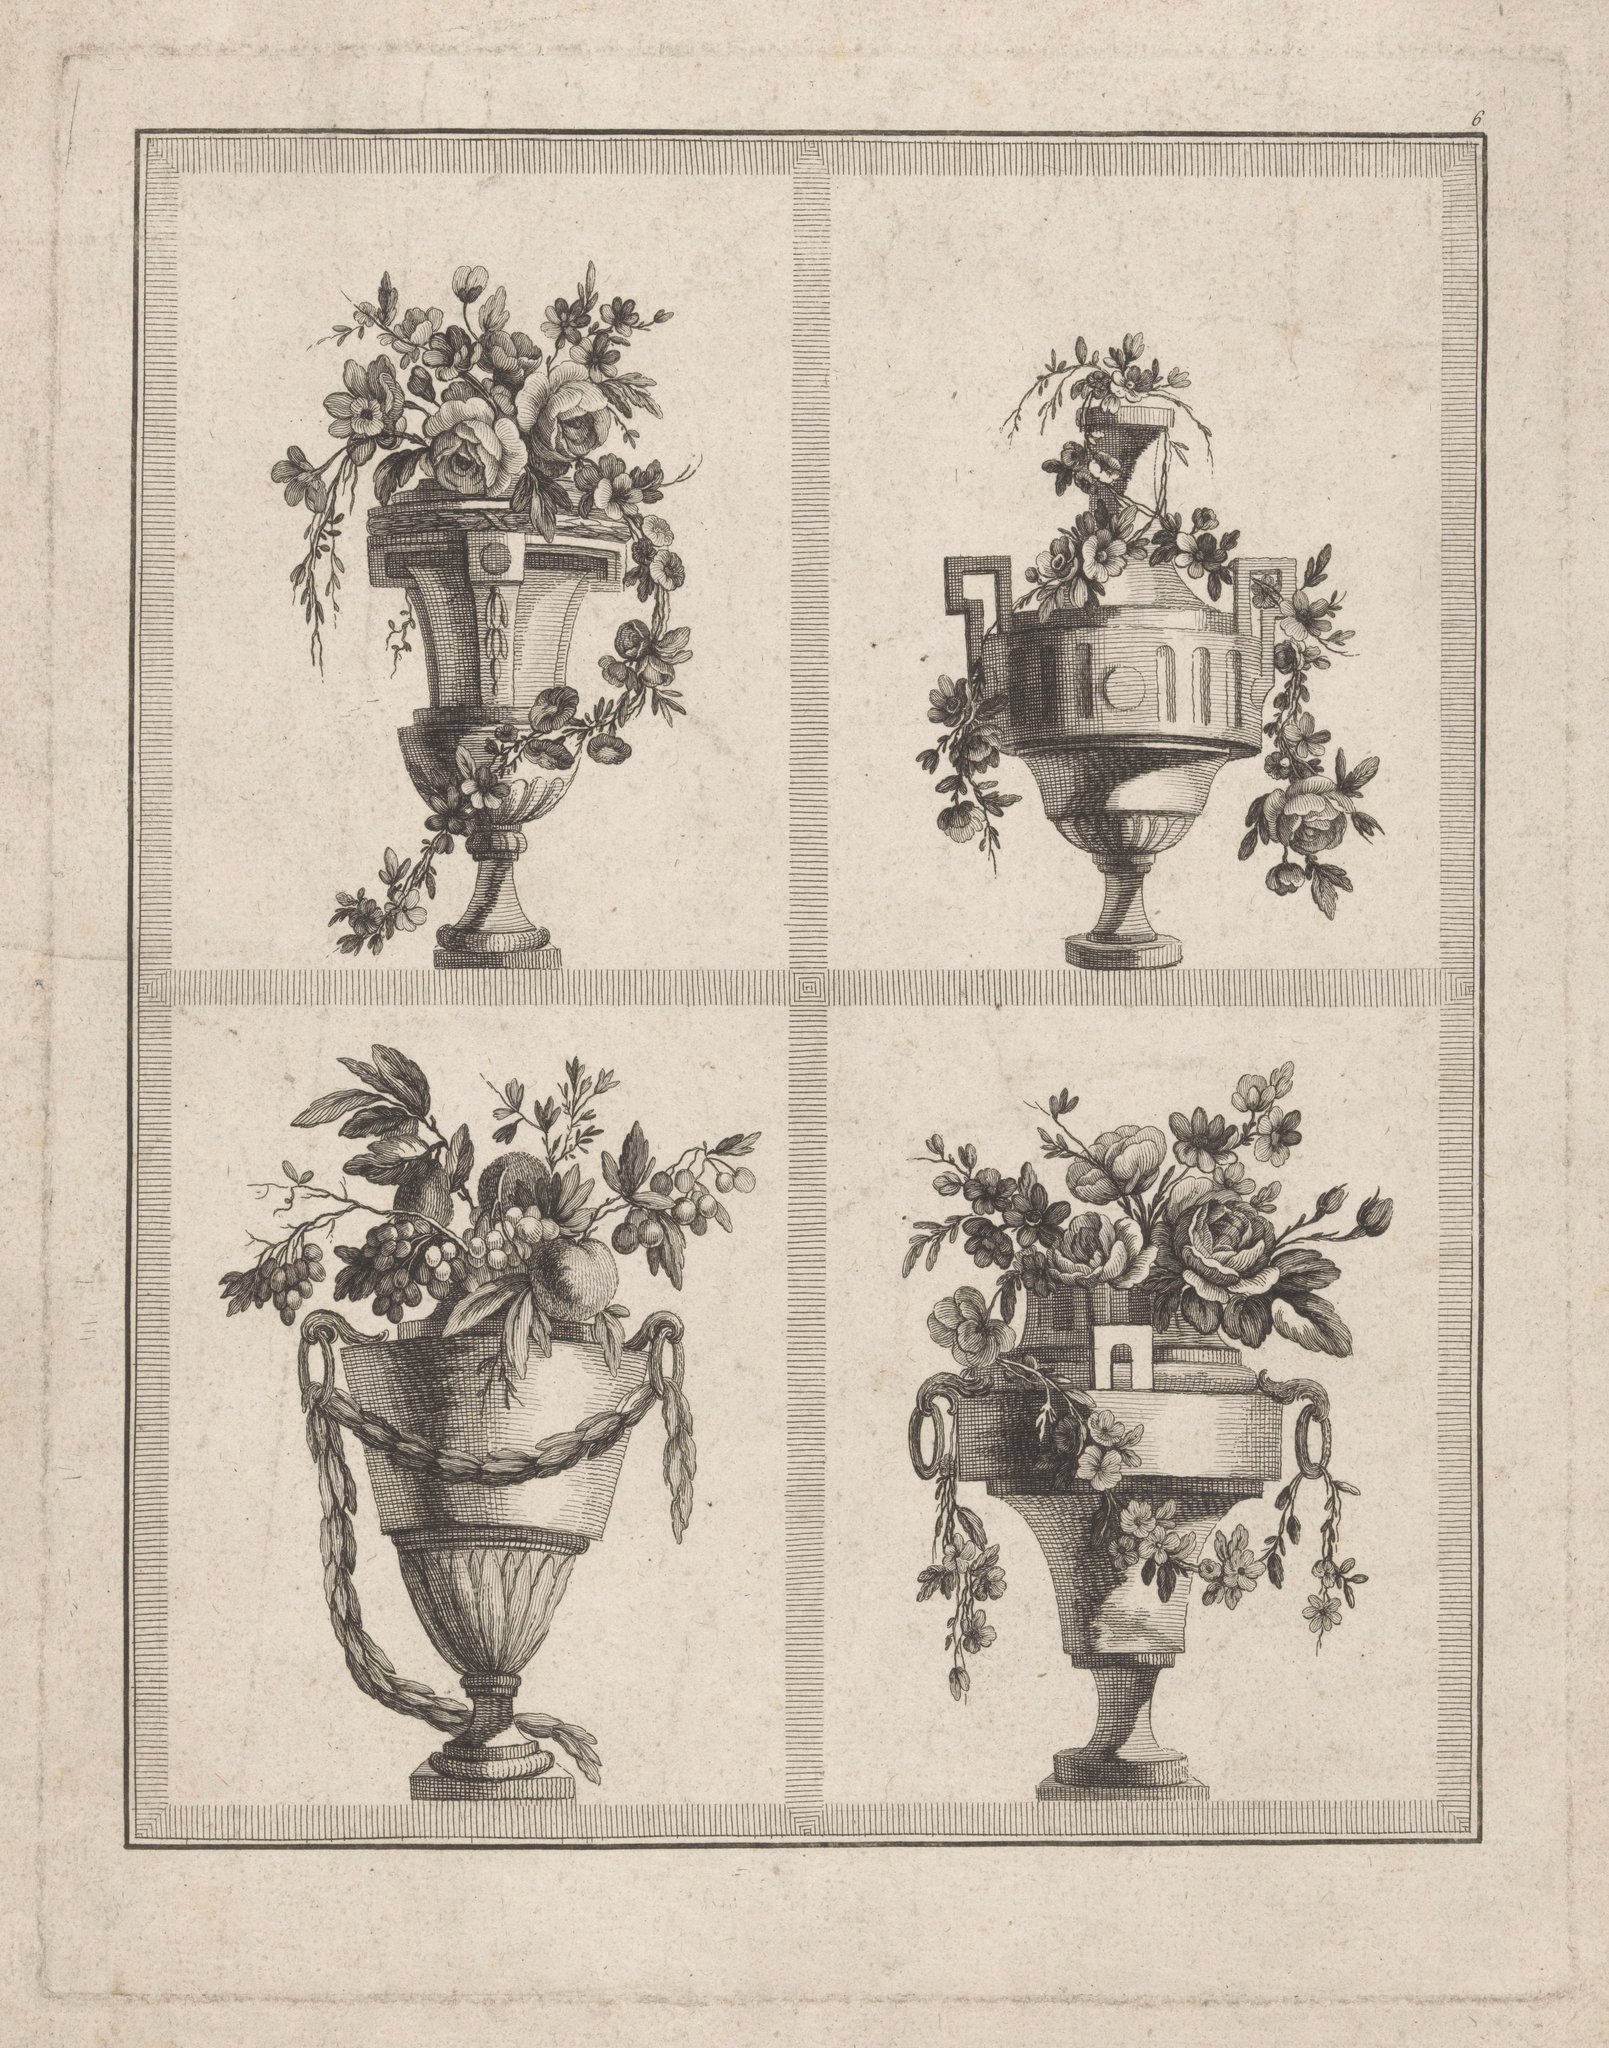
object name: print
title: 10e Cahier Cayé de Fleurs et Vases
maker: etienne claude voysard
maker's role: print maker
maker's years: 1746-1812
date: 1778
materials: paper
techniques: etching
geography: paris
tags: flowers in a vase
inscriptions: collector's mark: Lugt 2228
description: Vier geornamenteerde vazen met bloemen en guirlandes.